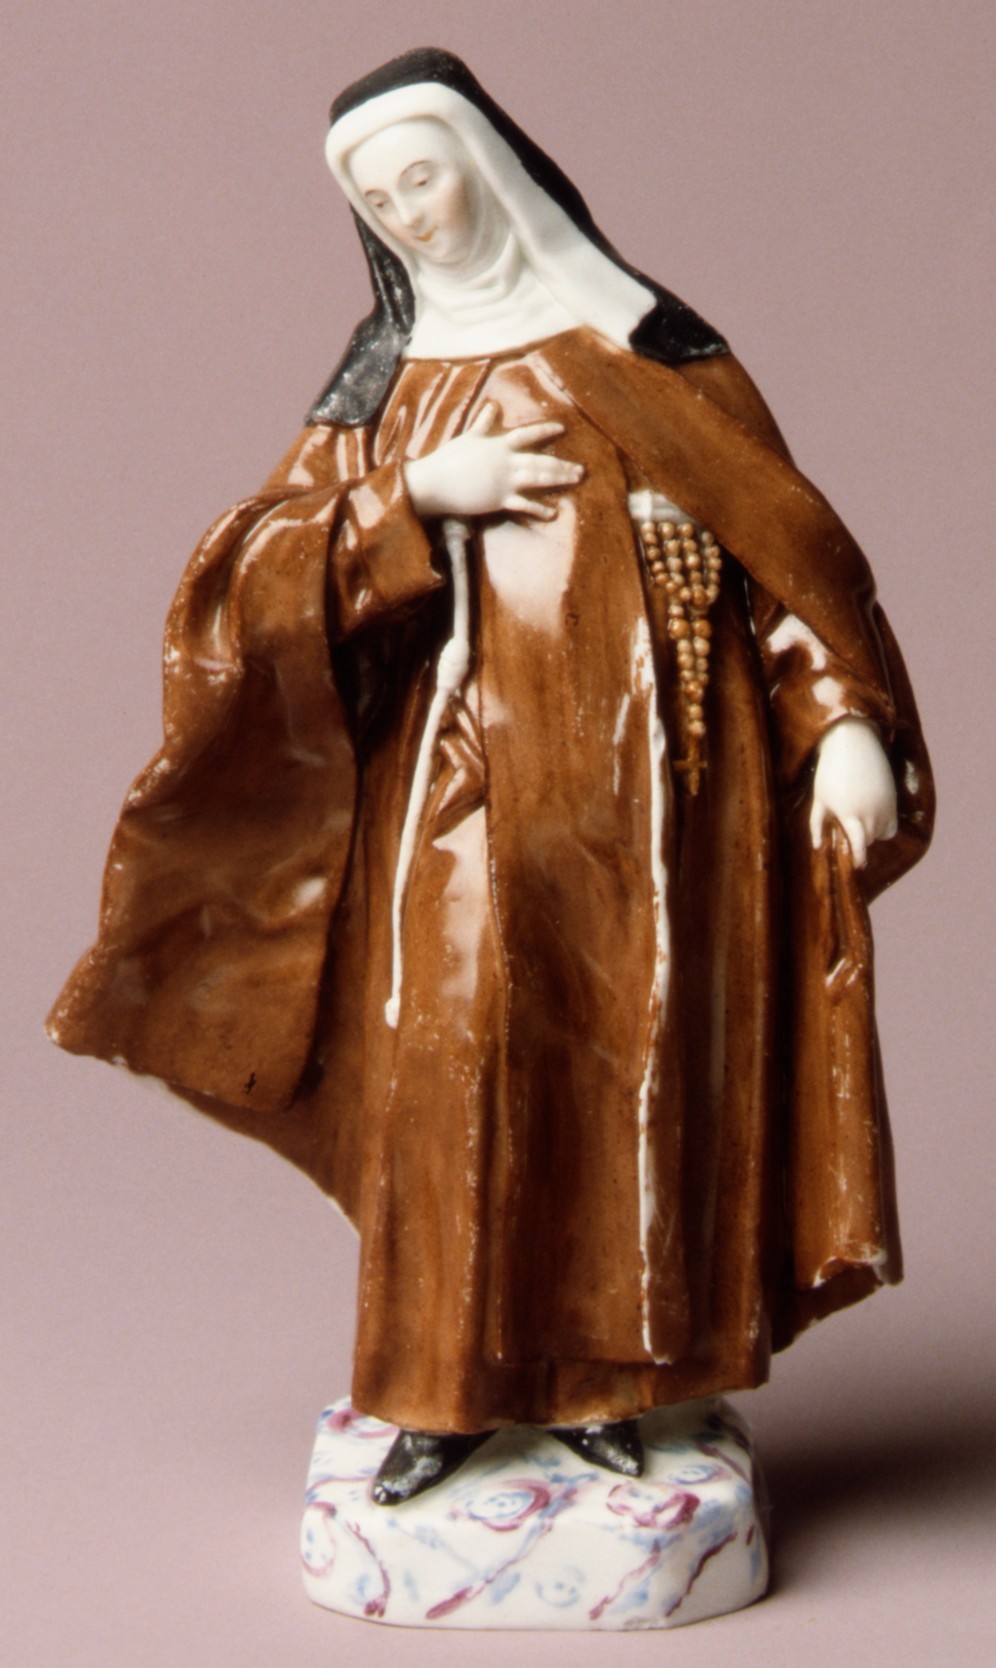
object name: figure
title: Franciscan Nun (one of a pair)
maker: höchst manufactory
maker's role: manufactory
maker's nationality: german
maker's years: 1746-1796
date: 1765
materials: hard paste porcelain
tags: women